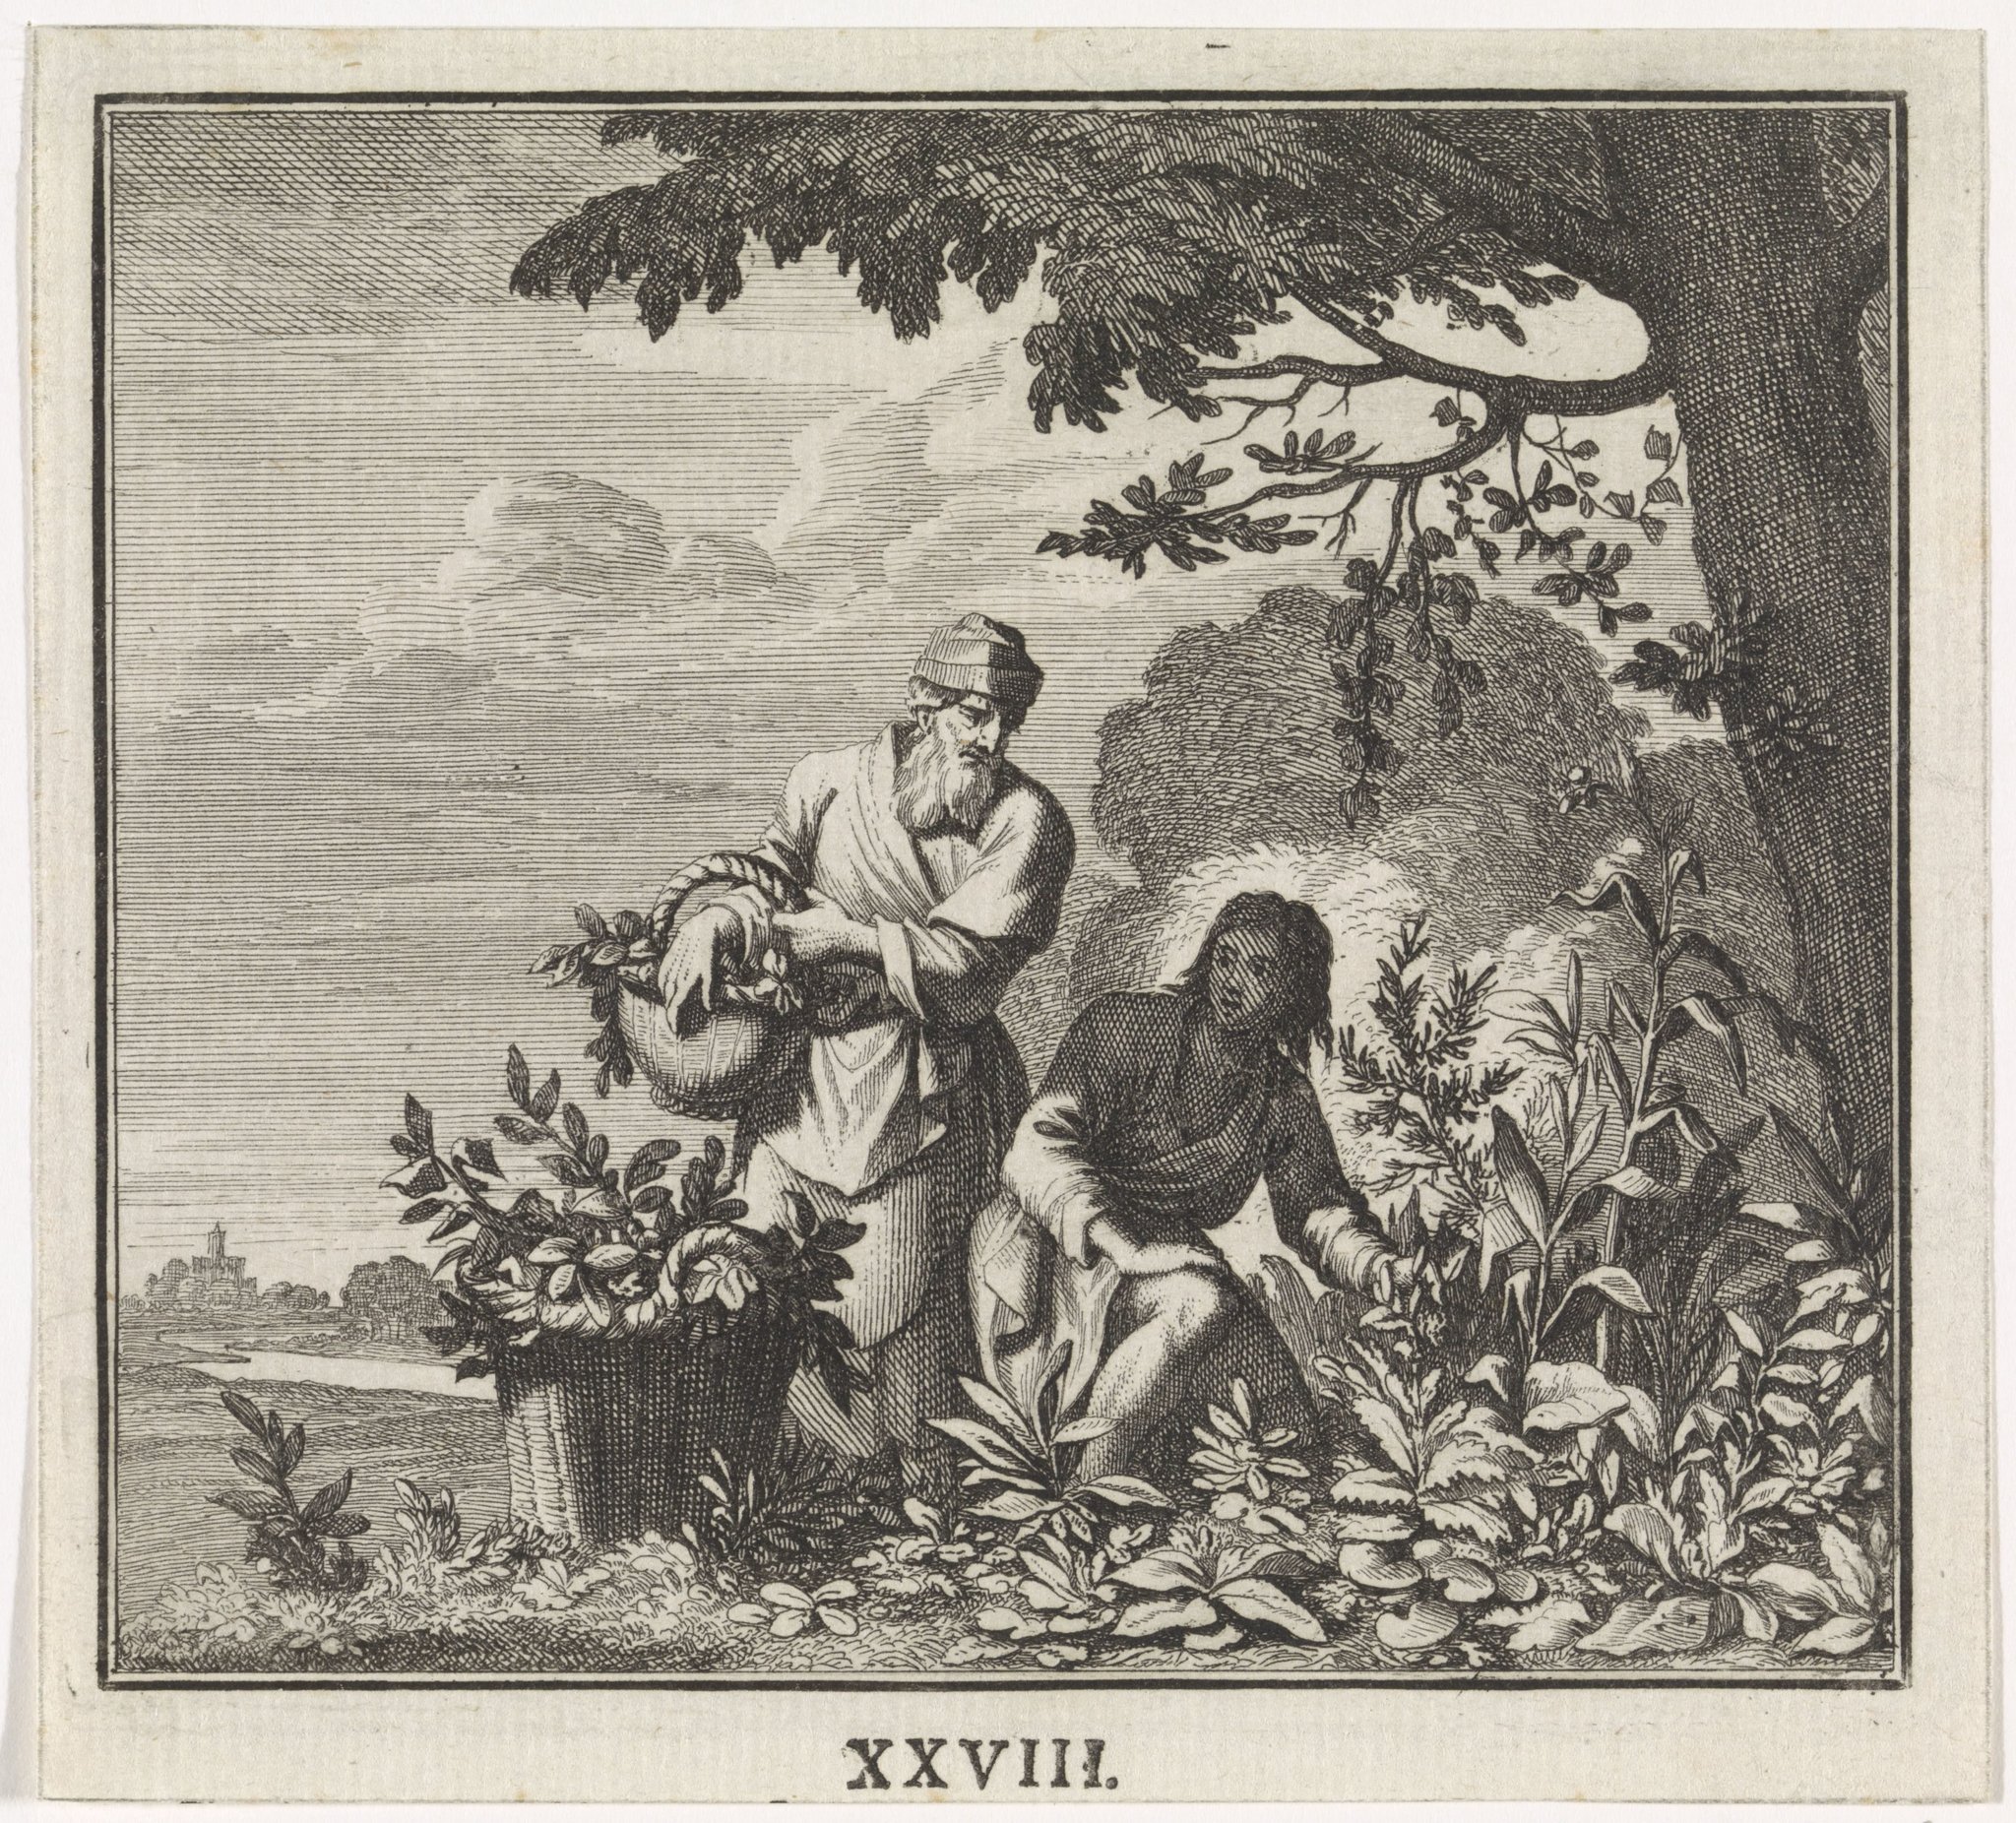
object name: book illustration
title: Twee mannen werken in een kruidentuin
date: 1700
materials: paper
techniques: etching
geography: nuremberg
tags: herb garden, gathering herbs, plants and herbs, abstract ideas and concepts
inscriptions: collector's mark: Lugt 2228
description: Boekillustratie voor Weigel, Christoph. Ethica Naturalis seu Documenta Moralia e Variis rerum Naturalium proprietatibus Virtutum Vitiorumq symbolicis imaginibus collecta. Neurenberg: Christoph Weigel: c. 1700.